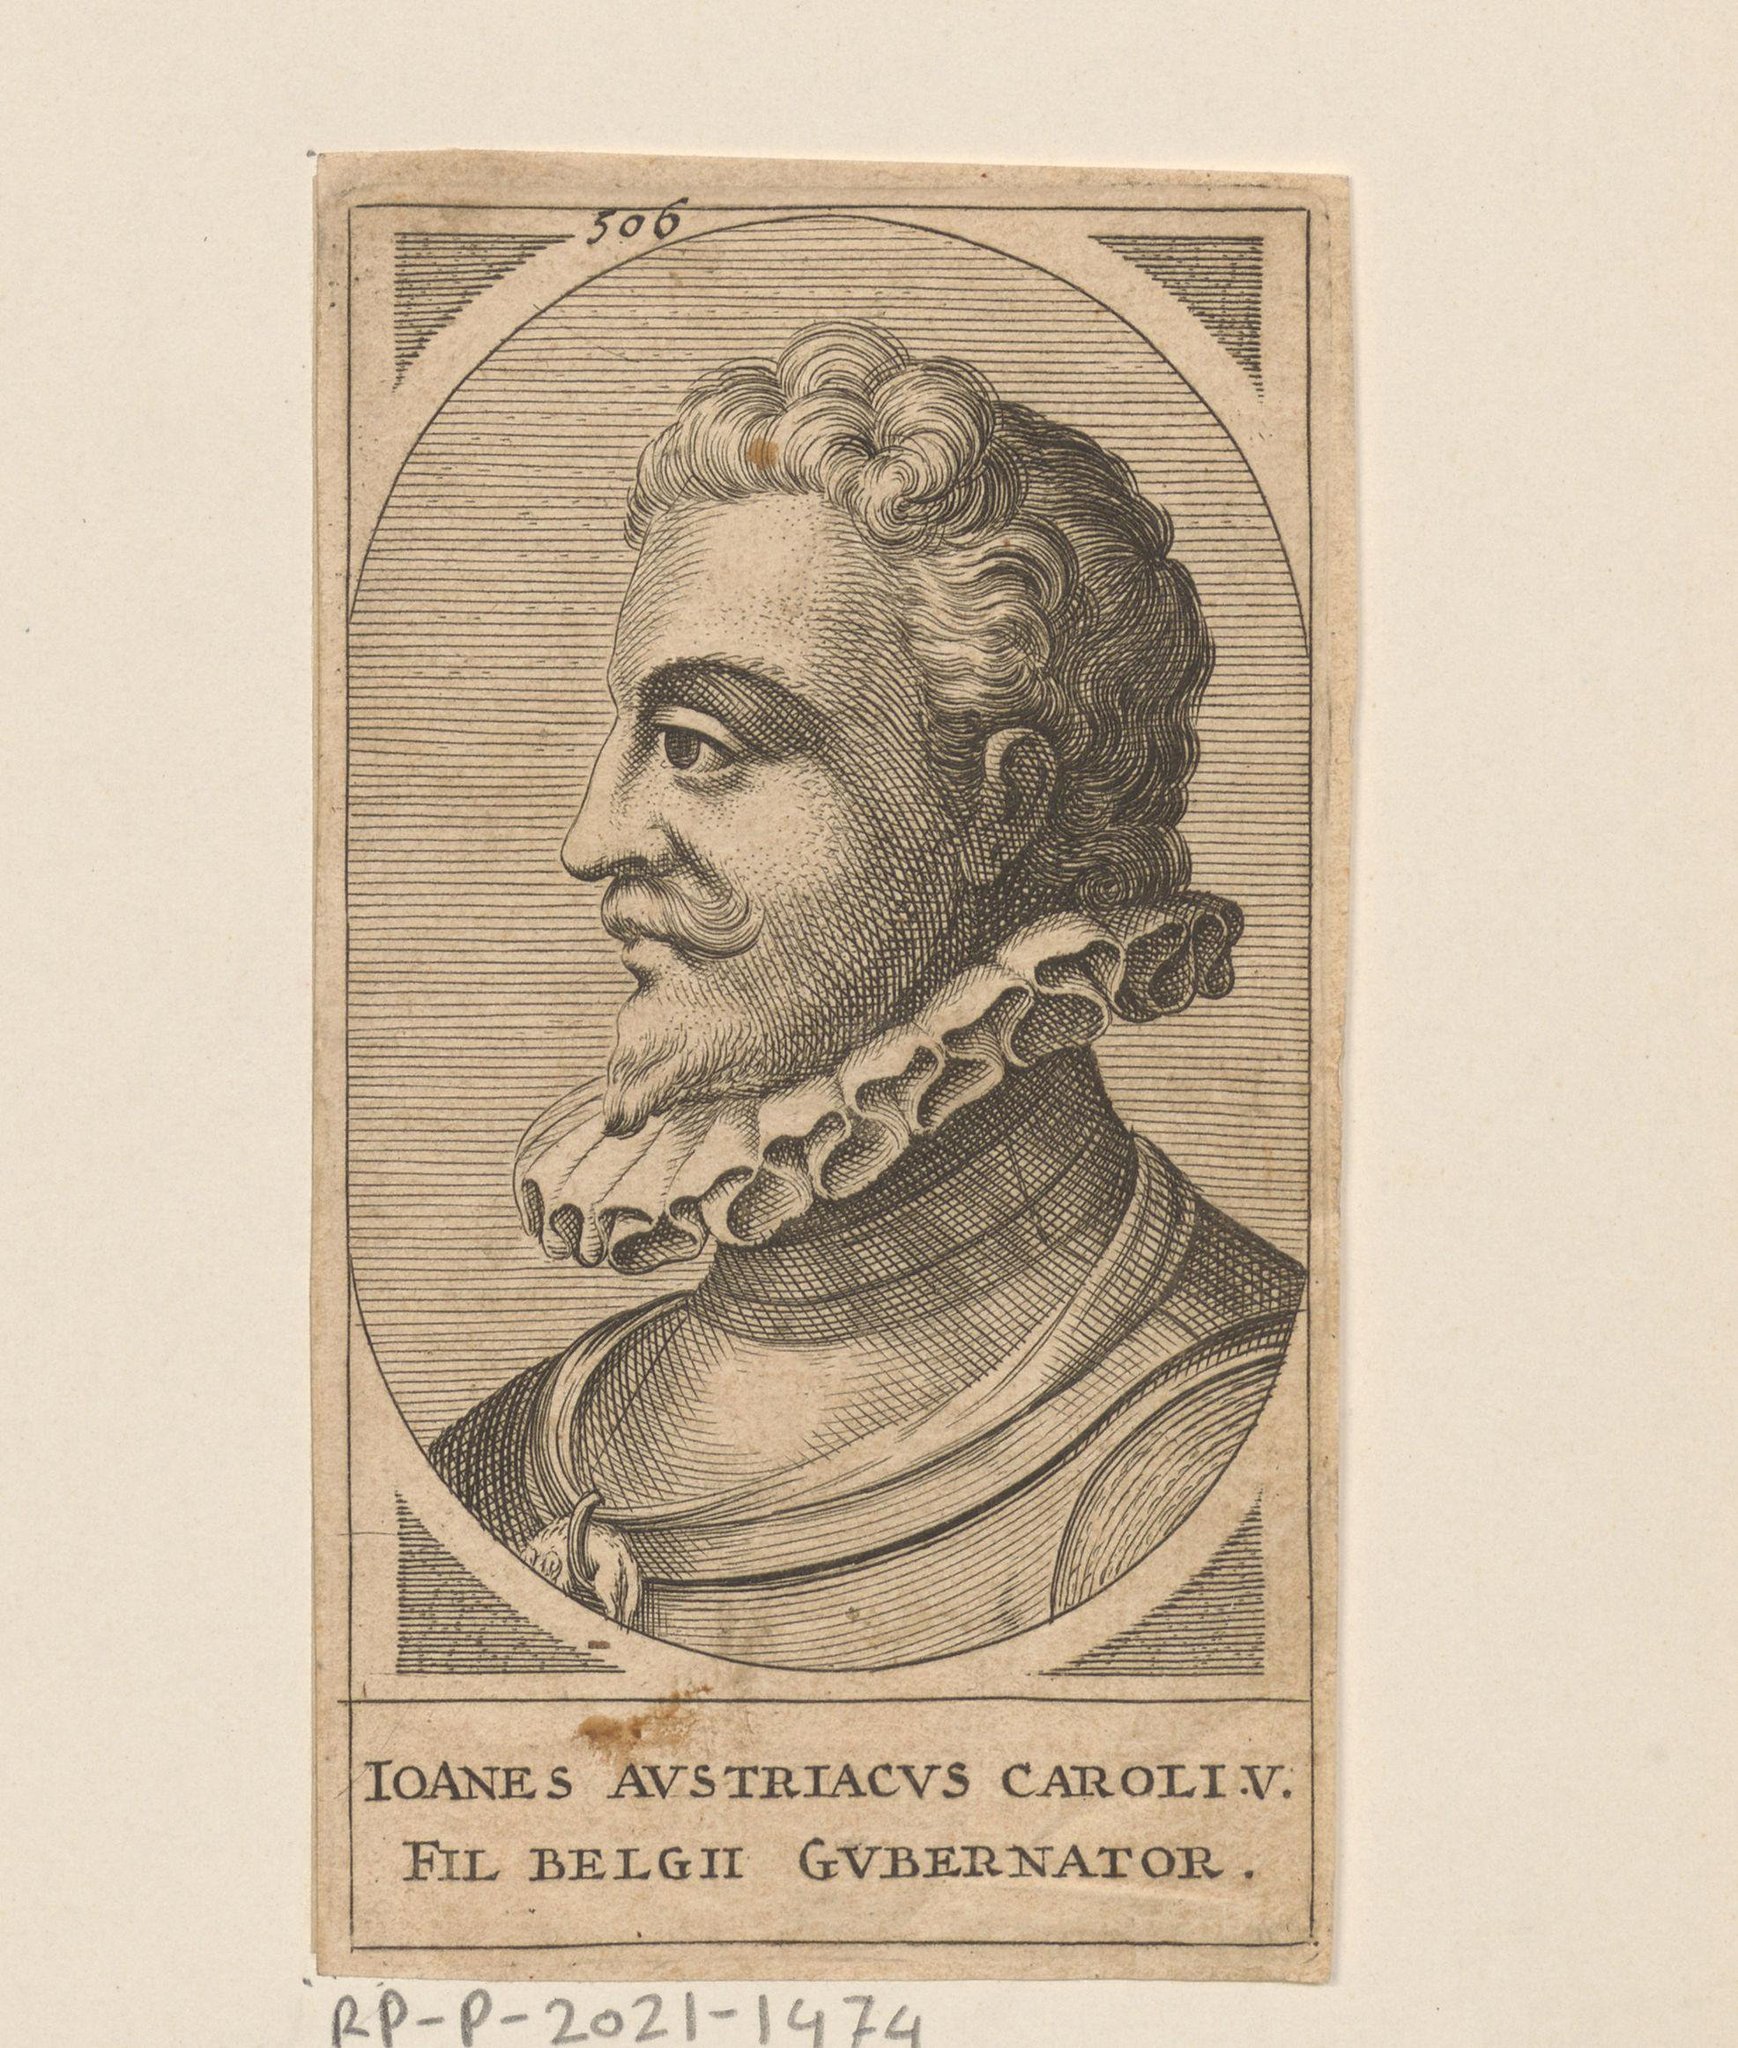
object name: print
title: Portret van Don Juan van Oostenrijk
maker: Anonymous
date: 1648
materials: paper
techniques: engraving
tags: don juan van oostenrijk, historical persons, knighthood order of the golden fleece, ruler, sovereign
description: Prent mogelijk uit: Strada, Famiano. De bello Belgico decas prima (...). Rome: Hermann Scheus, 1648, dl. 1.